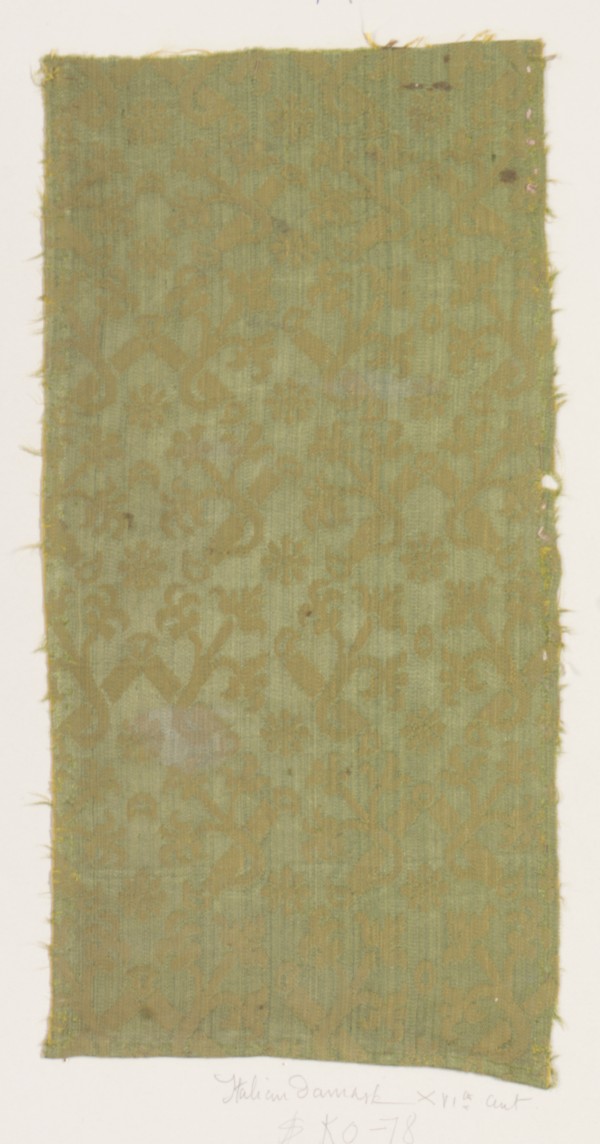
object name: fragment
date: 1501-1600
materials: silk